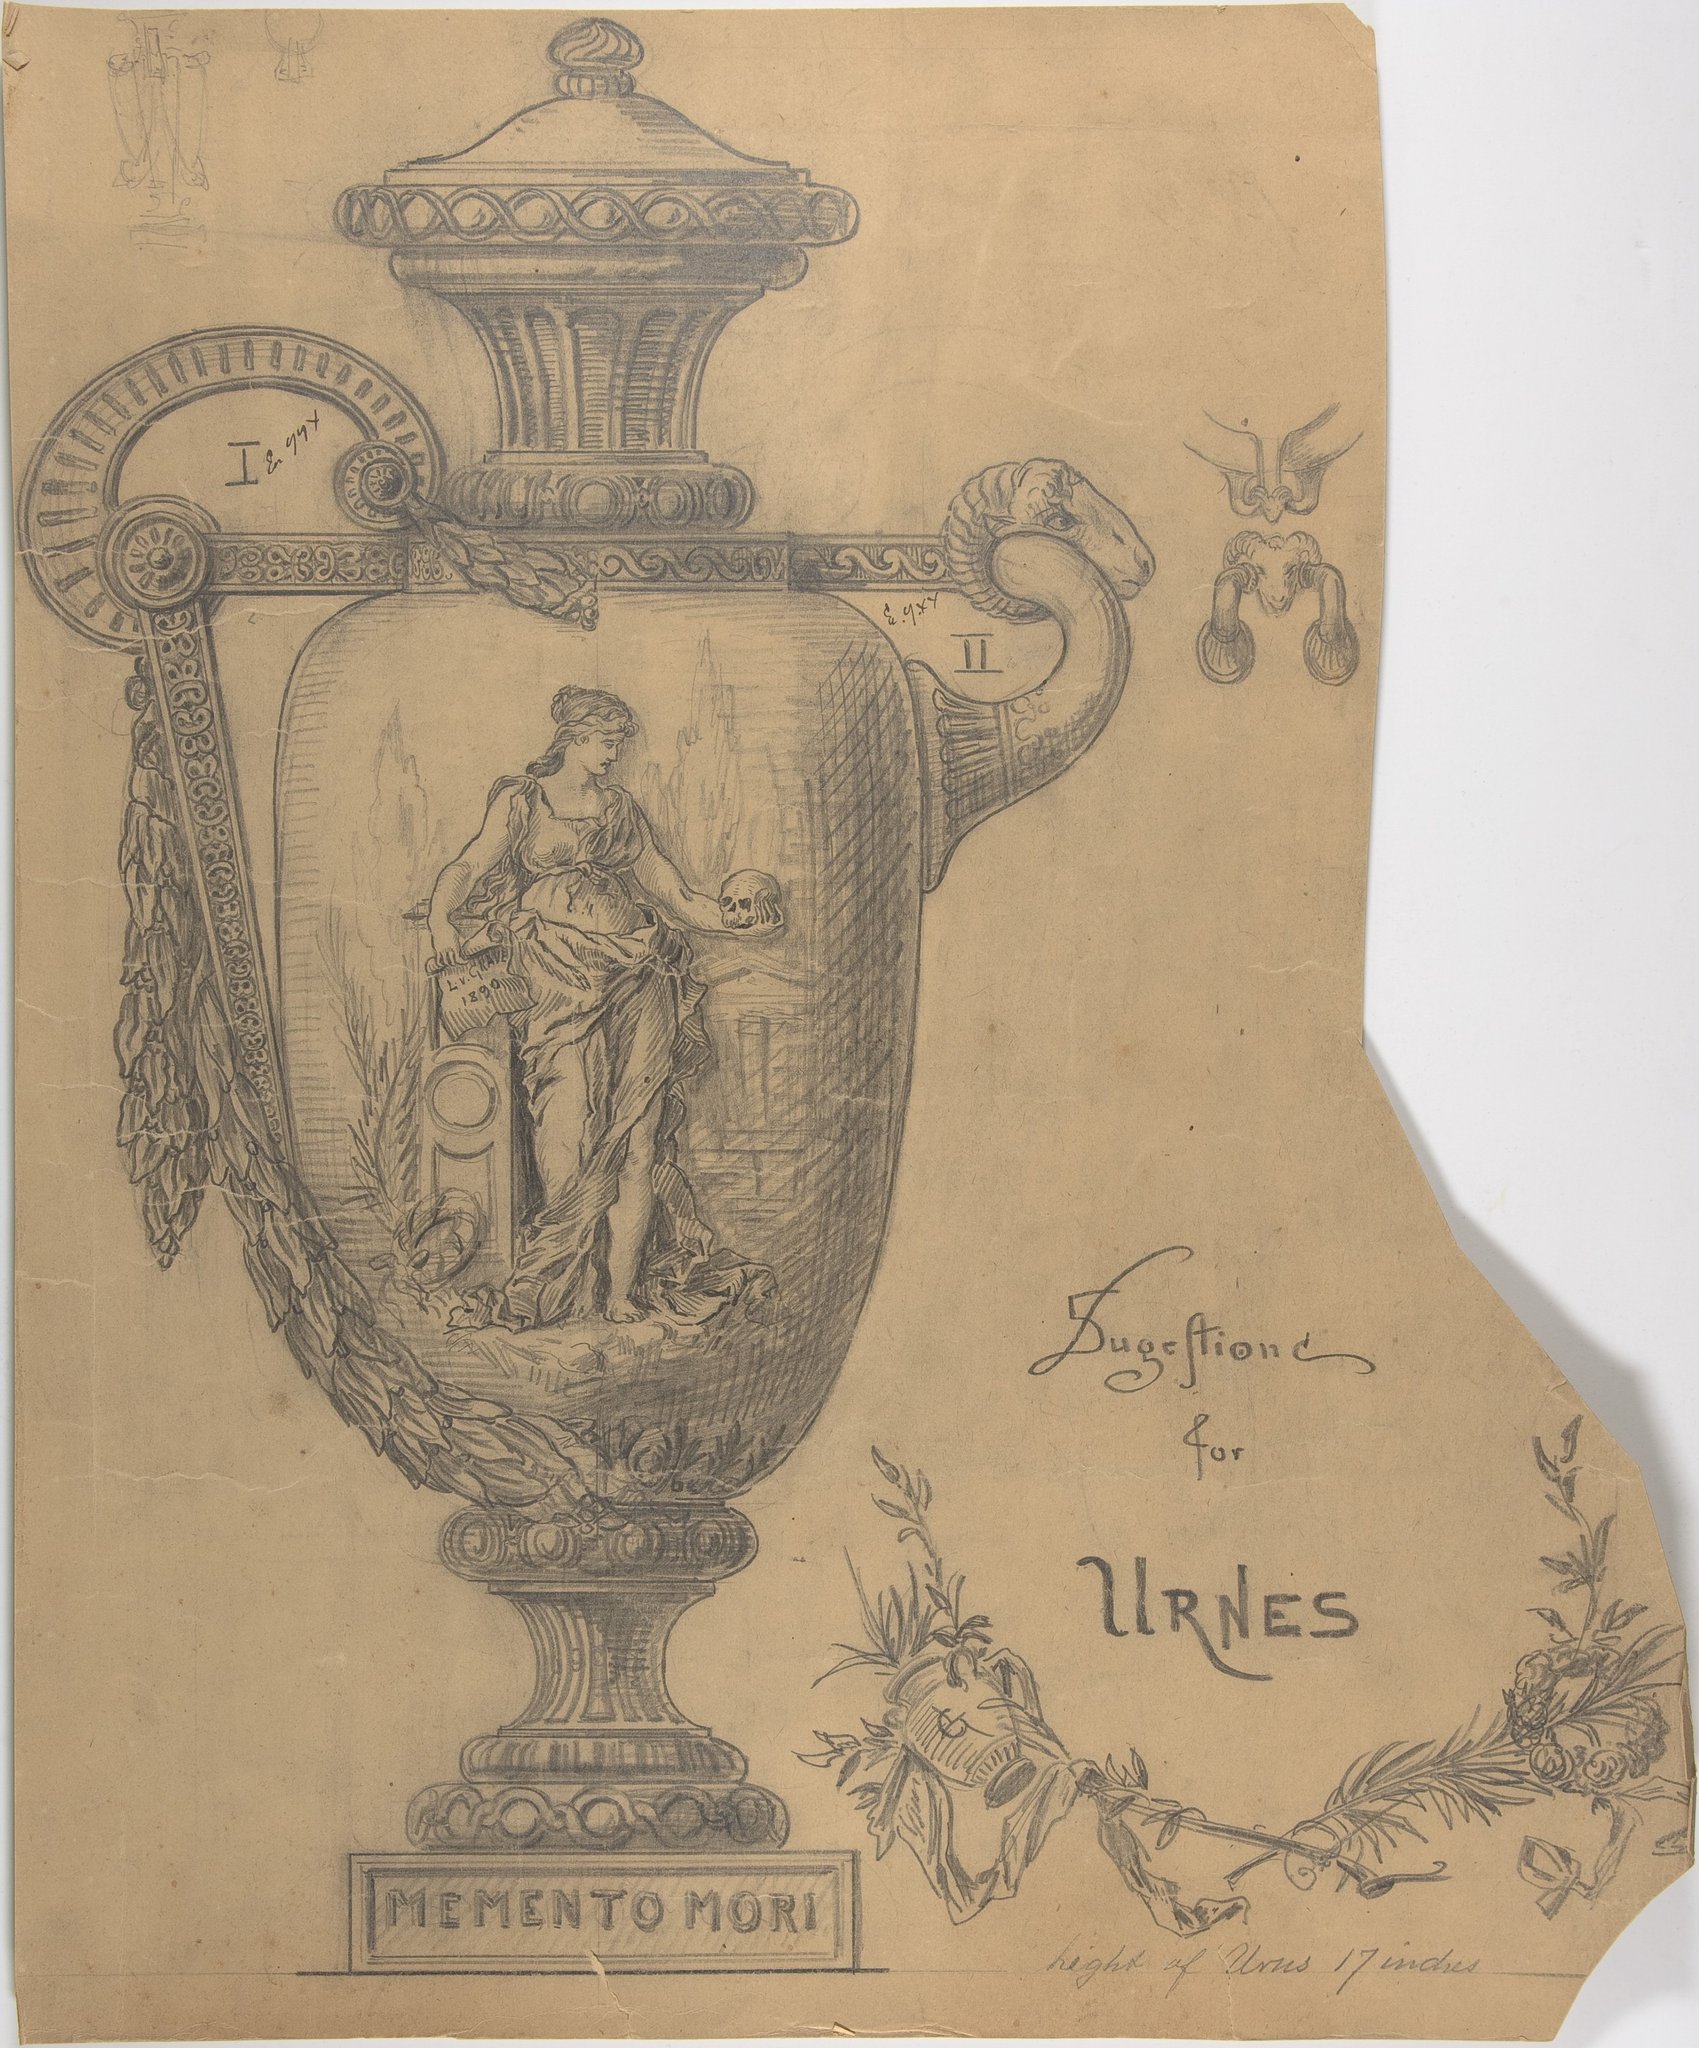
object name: drawing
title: Suggestions for Urns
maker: l. v. grave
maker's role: artist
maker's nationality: british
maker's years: 18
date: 1701-1800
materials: graphite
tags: skulls,women,urns